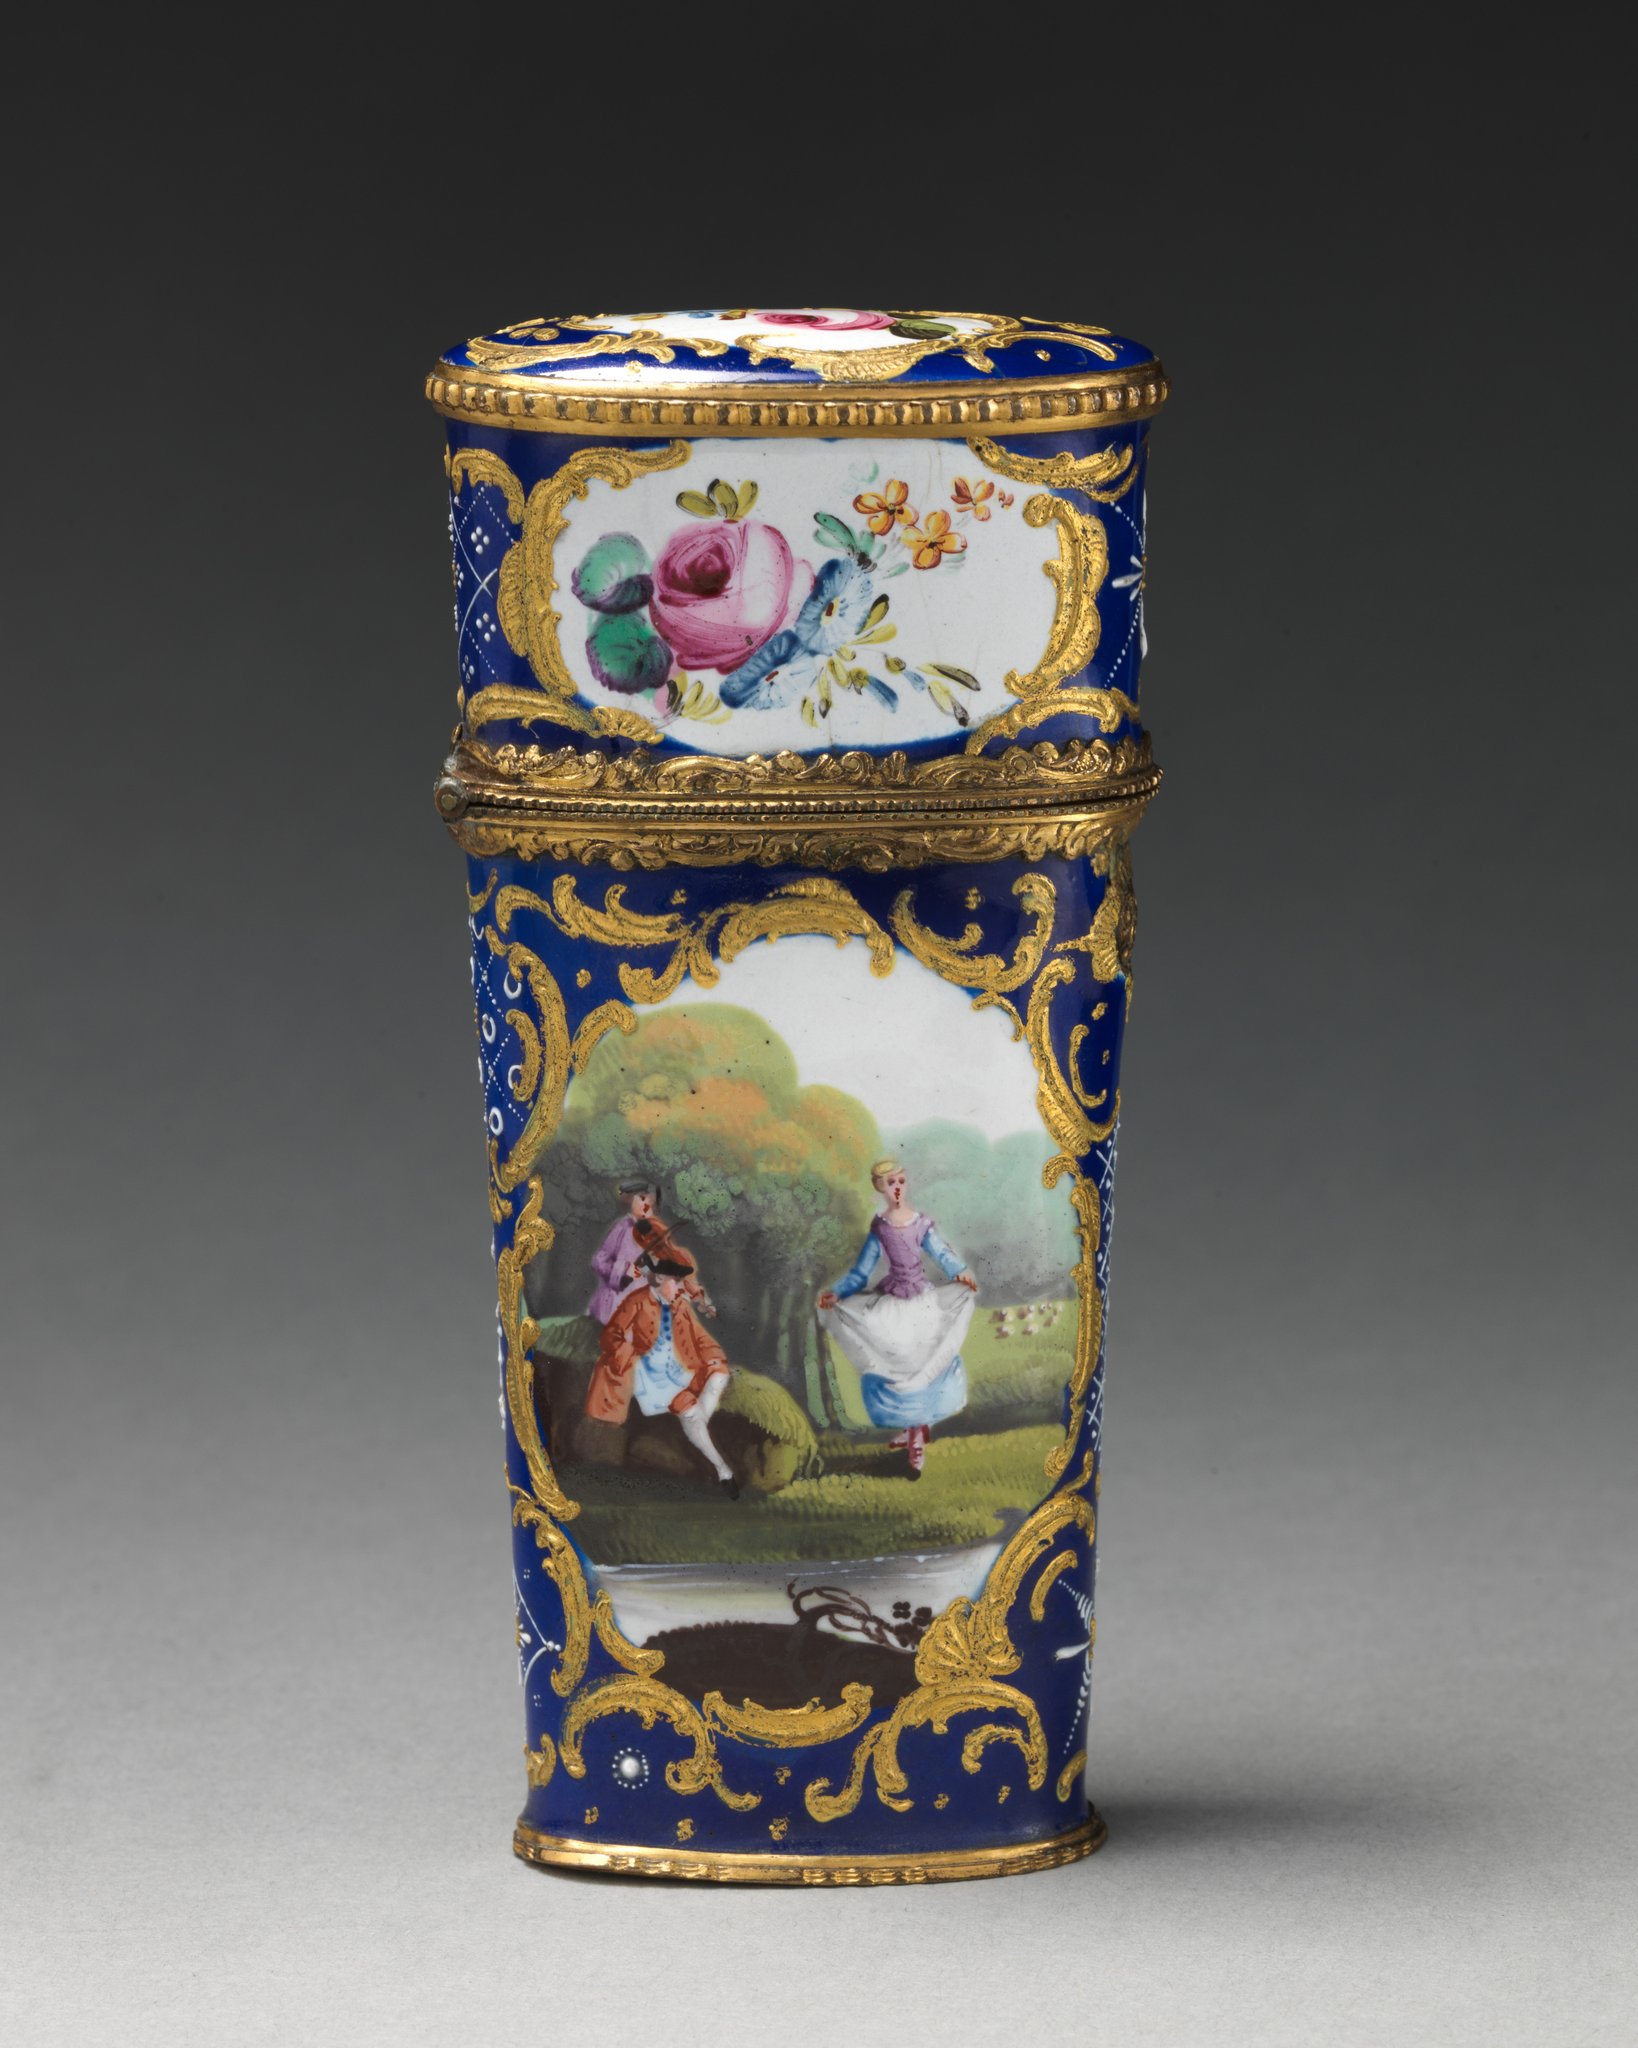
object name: étui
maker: robert sayer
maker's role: publisher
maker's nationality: british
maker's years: 1725-1794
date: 1765-1770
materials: copper, enamel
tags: men,tulips,trees